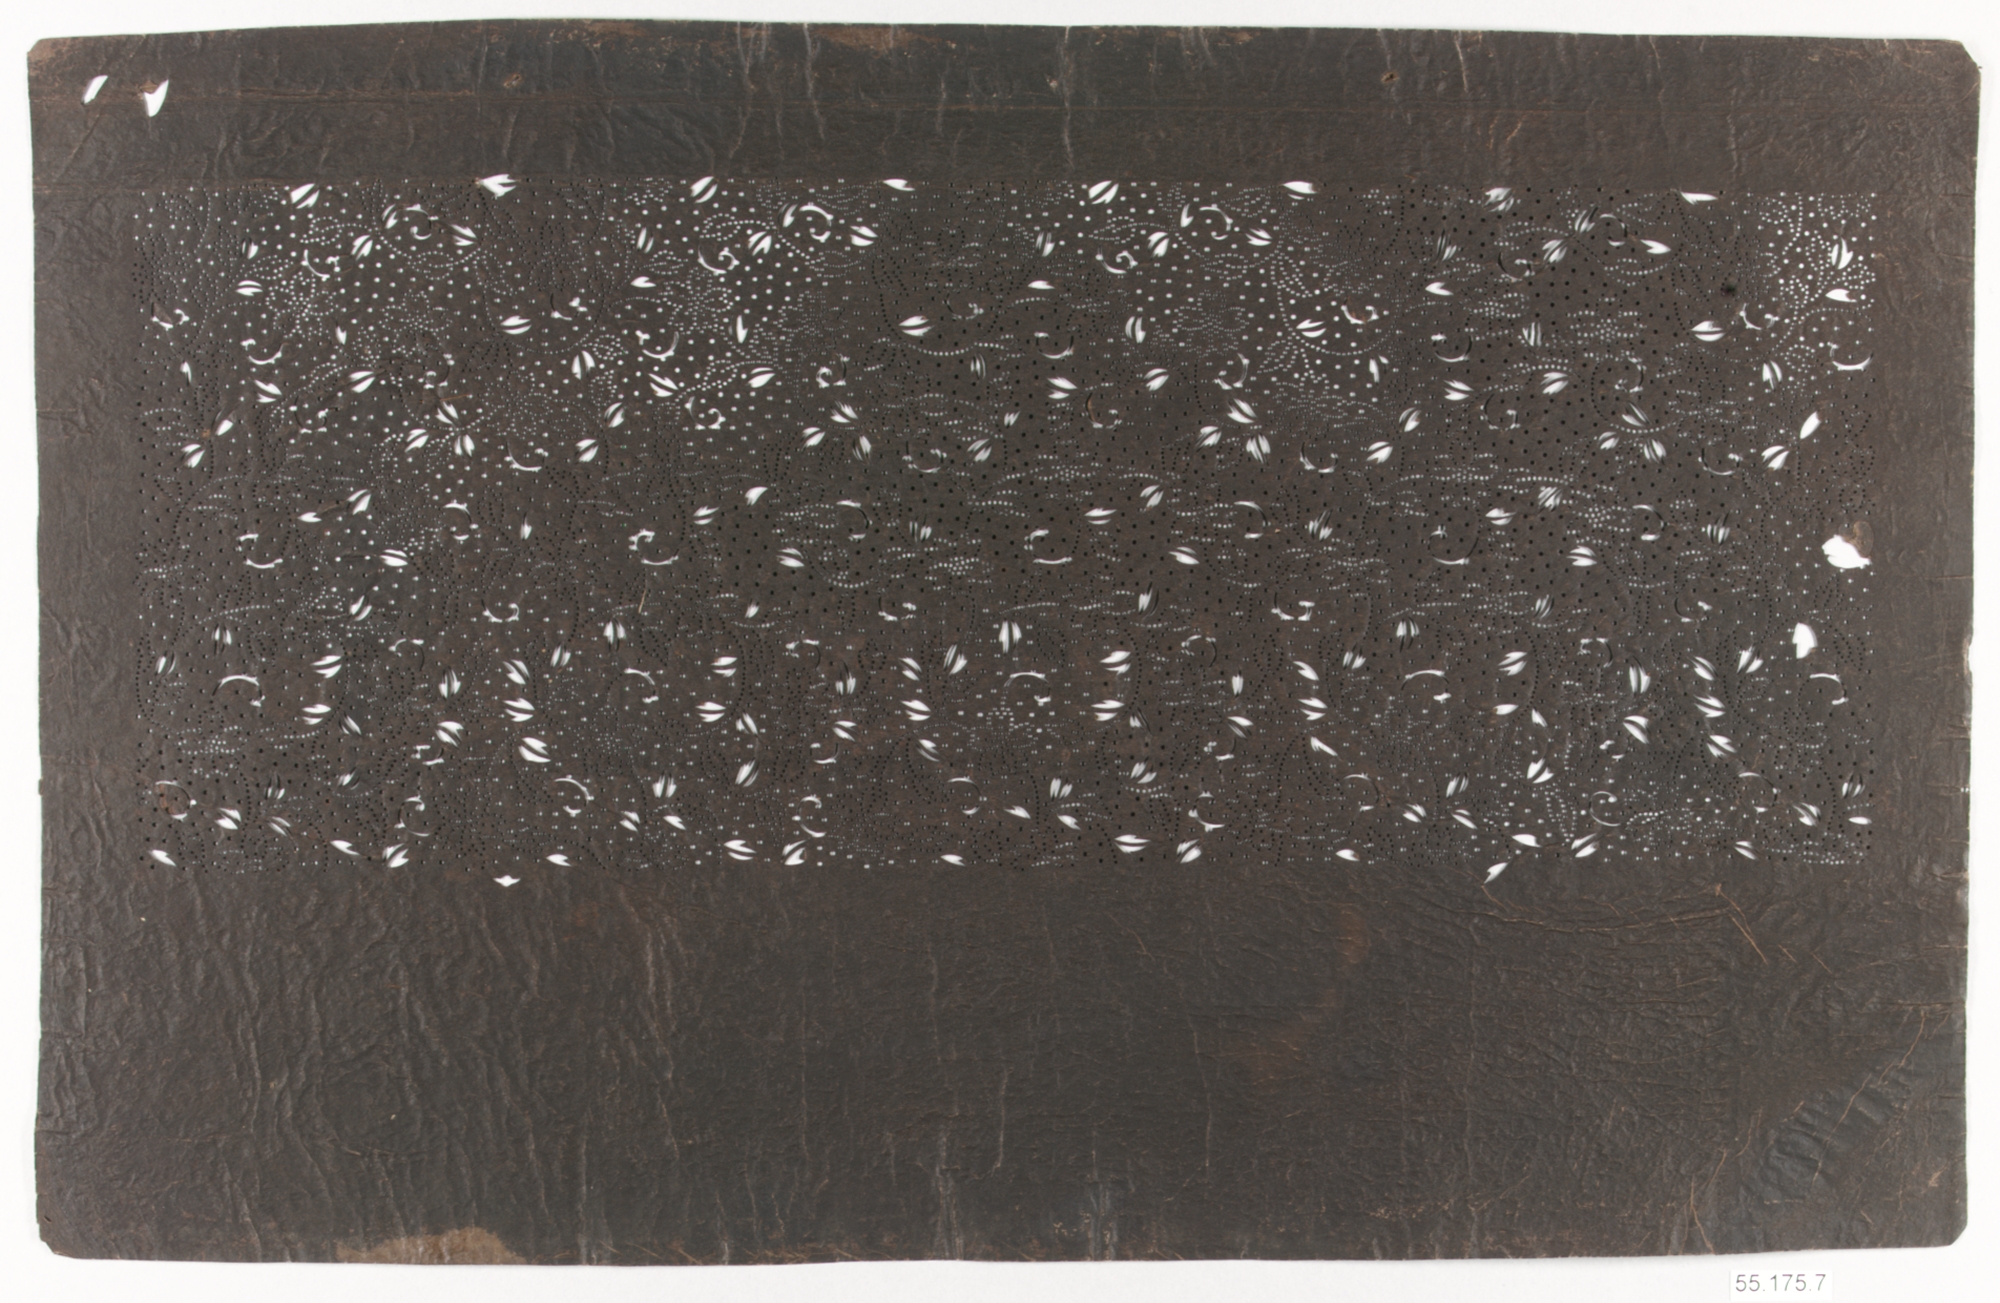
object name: stencil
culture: japanese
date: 1801-1900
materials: paper